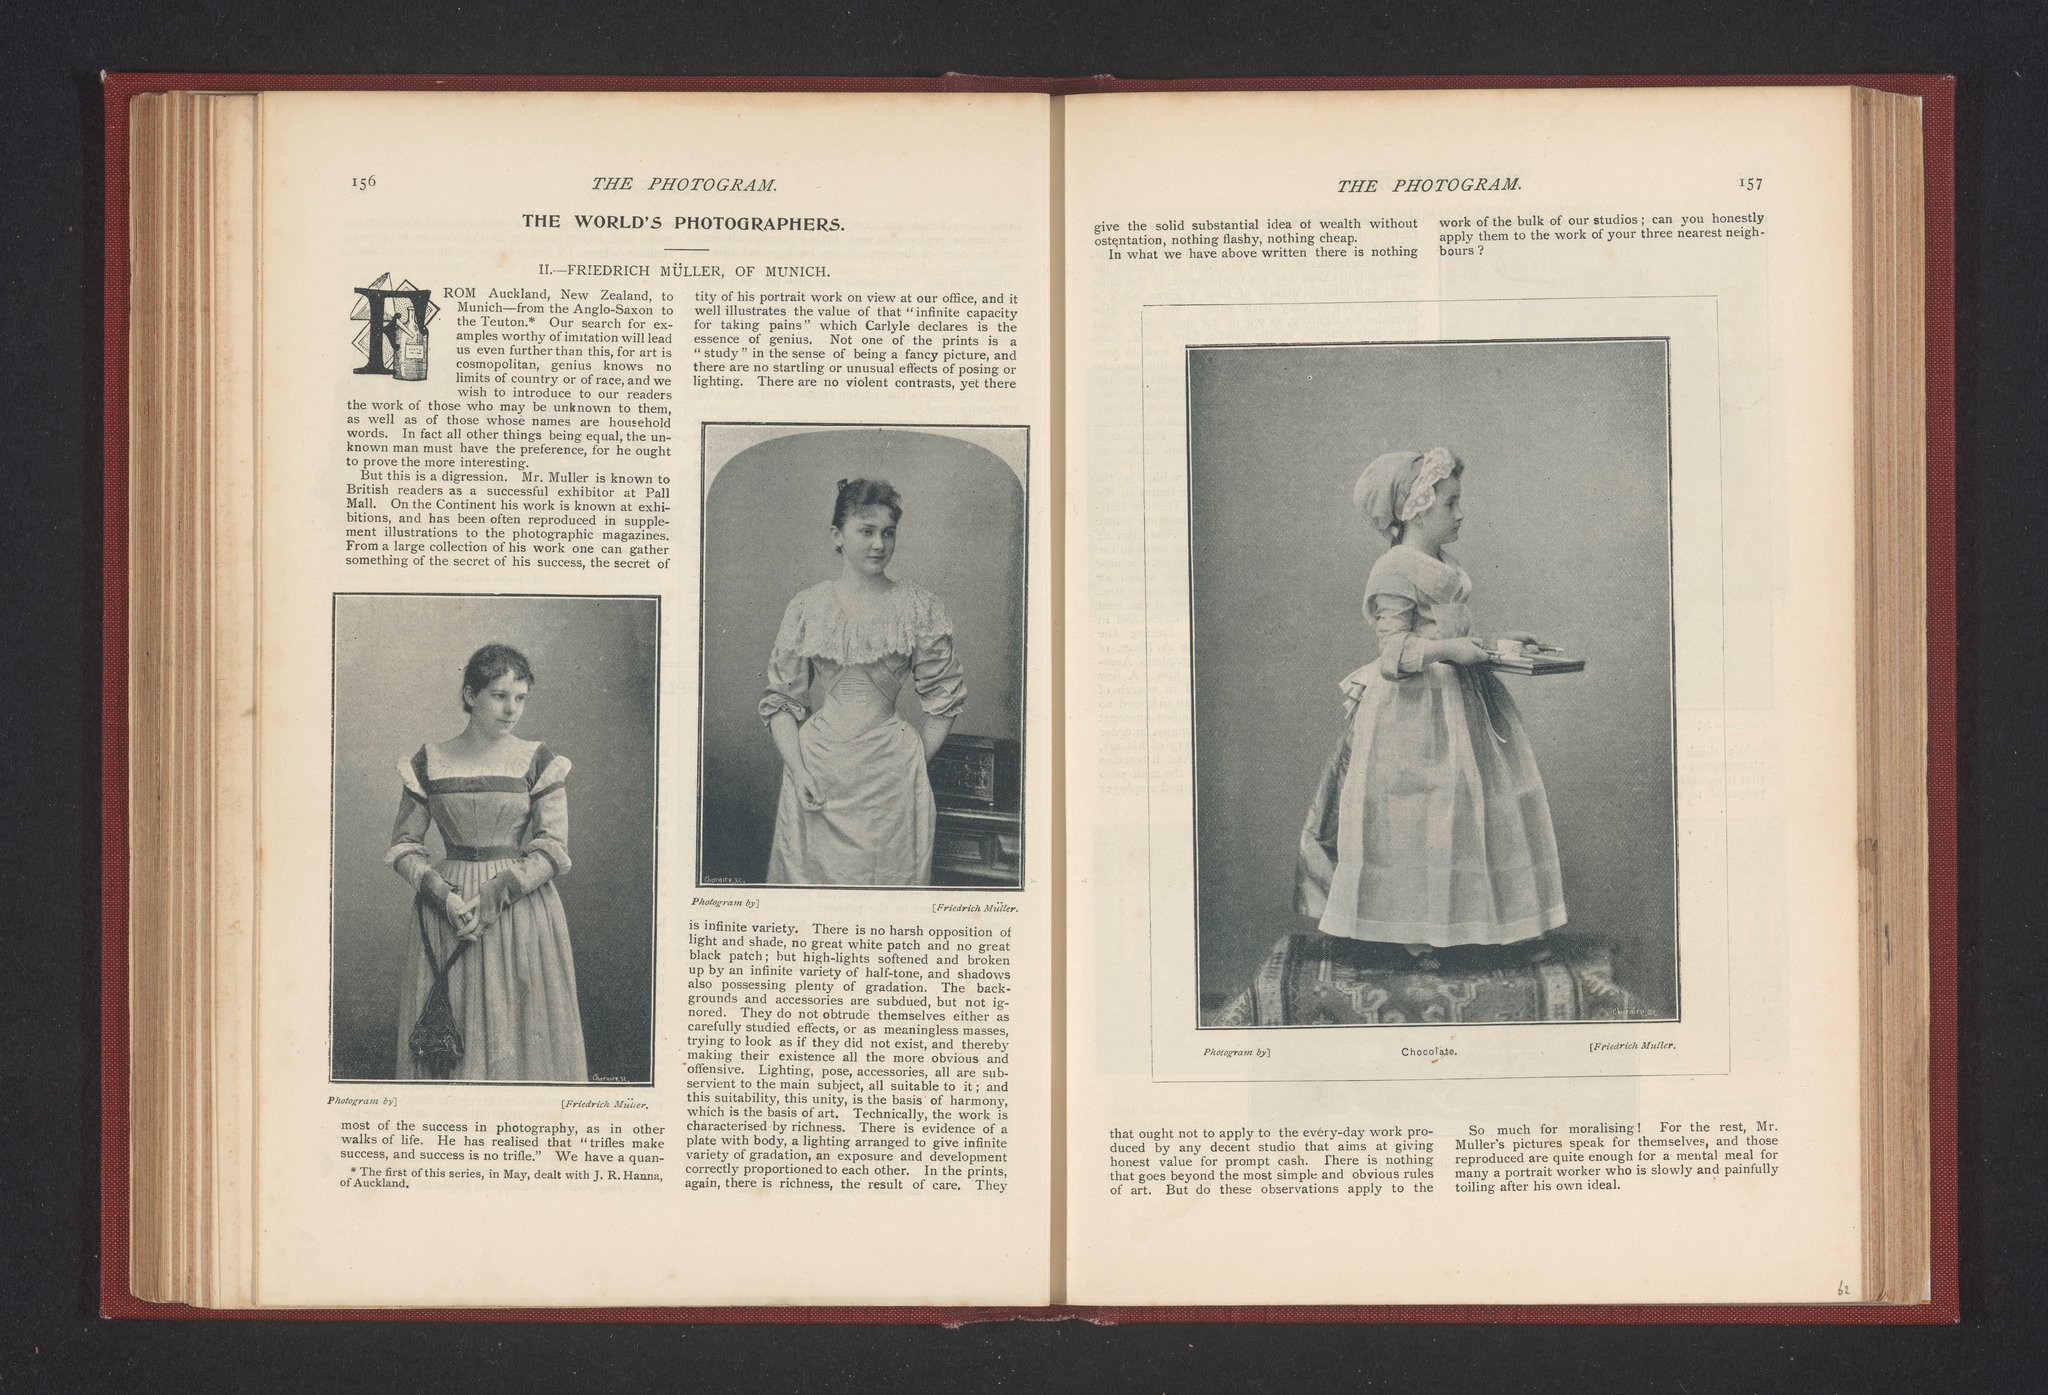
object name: photomechanical print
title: Portret van een onbekend jong meisje met dienblad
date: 1889-1894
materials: paper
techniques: autotype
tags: serving-dish, platter, historical persons - bb - woman